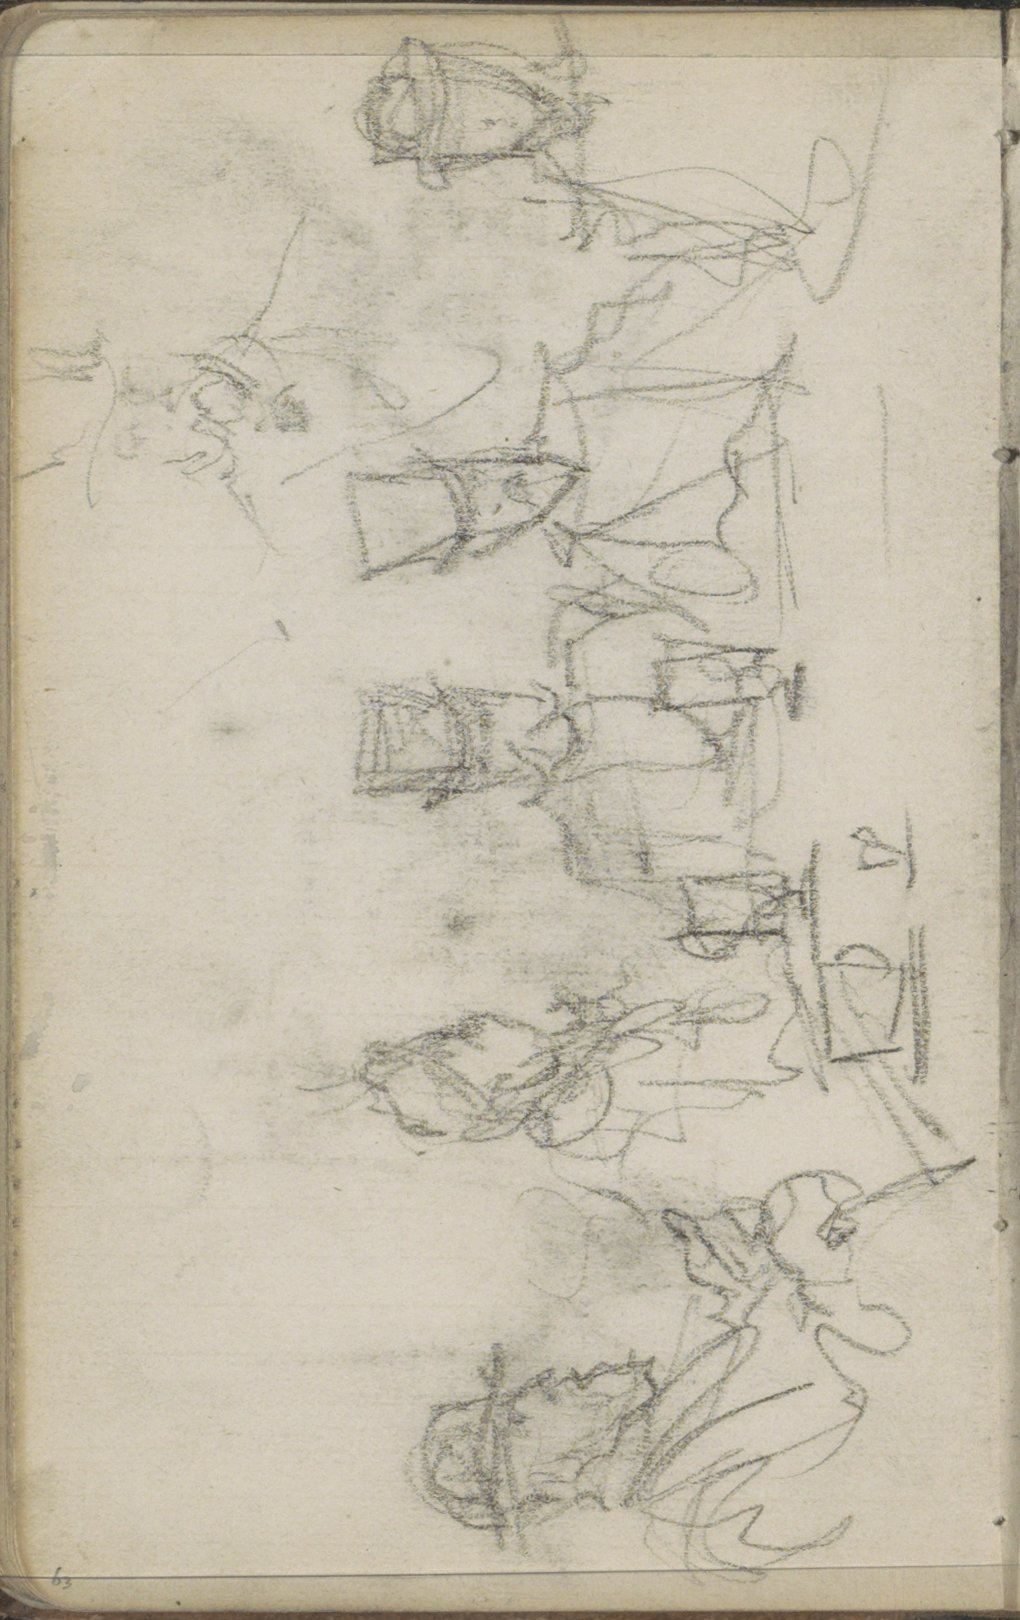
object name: sketchbook leaf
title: Mannen en vrouwen aan een tafel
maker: marius bauer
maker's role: draughtsman, print maker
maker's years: 1867-1932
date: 1879-1885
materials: chalk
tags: sitting figure, adult woman, adult man, inn, coffee-house, public house, etc., cup, glass, rummer, head-gear: top hat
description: Op de tafel staan glazen en een kop. Mogelijk bevinden de figuren zich in een café. Pagina 63 uit een schetsboek met 58 bladen.